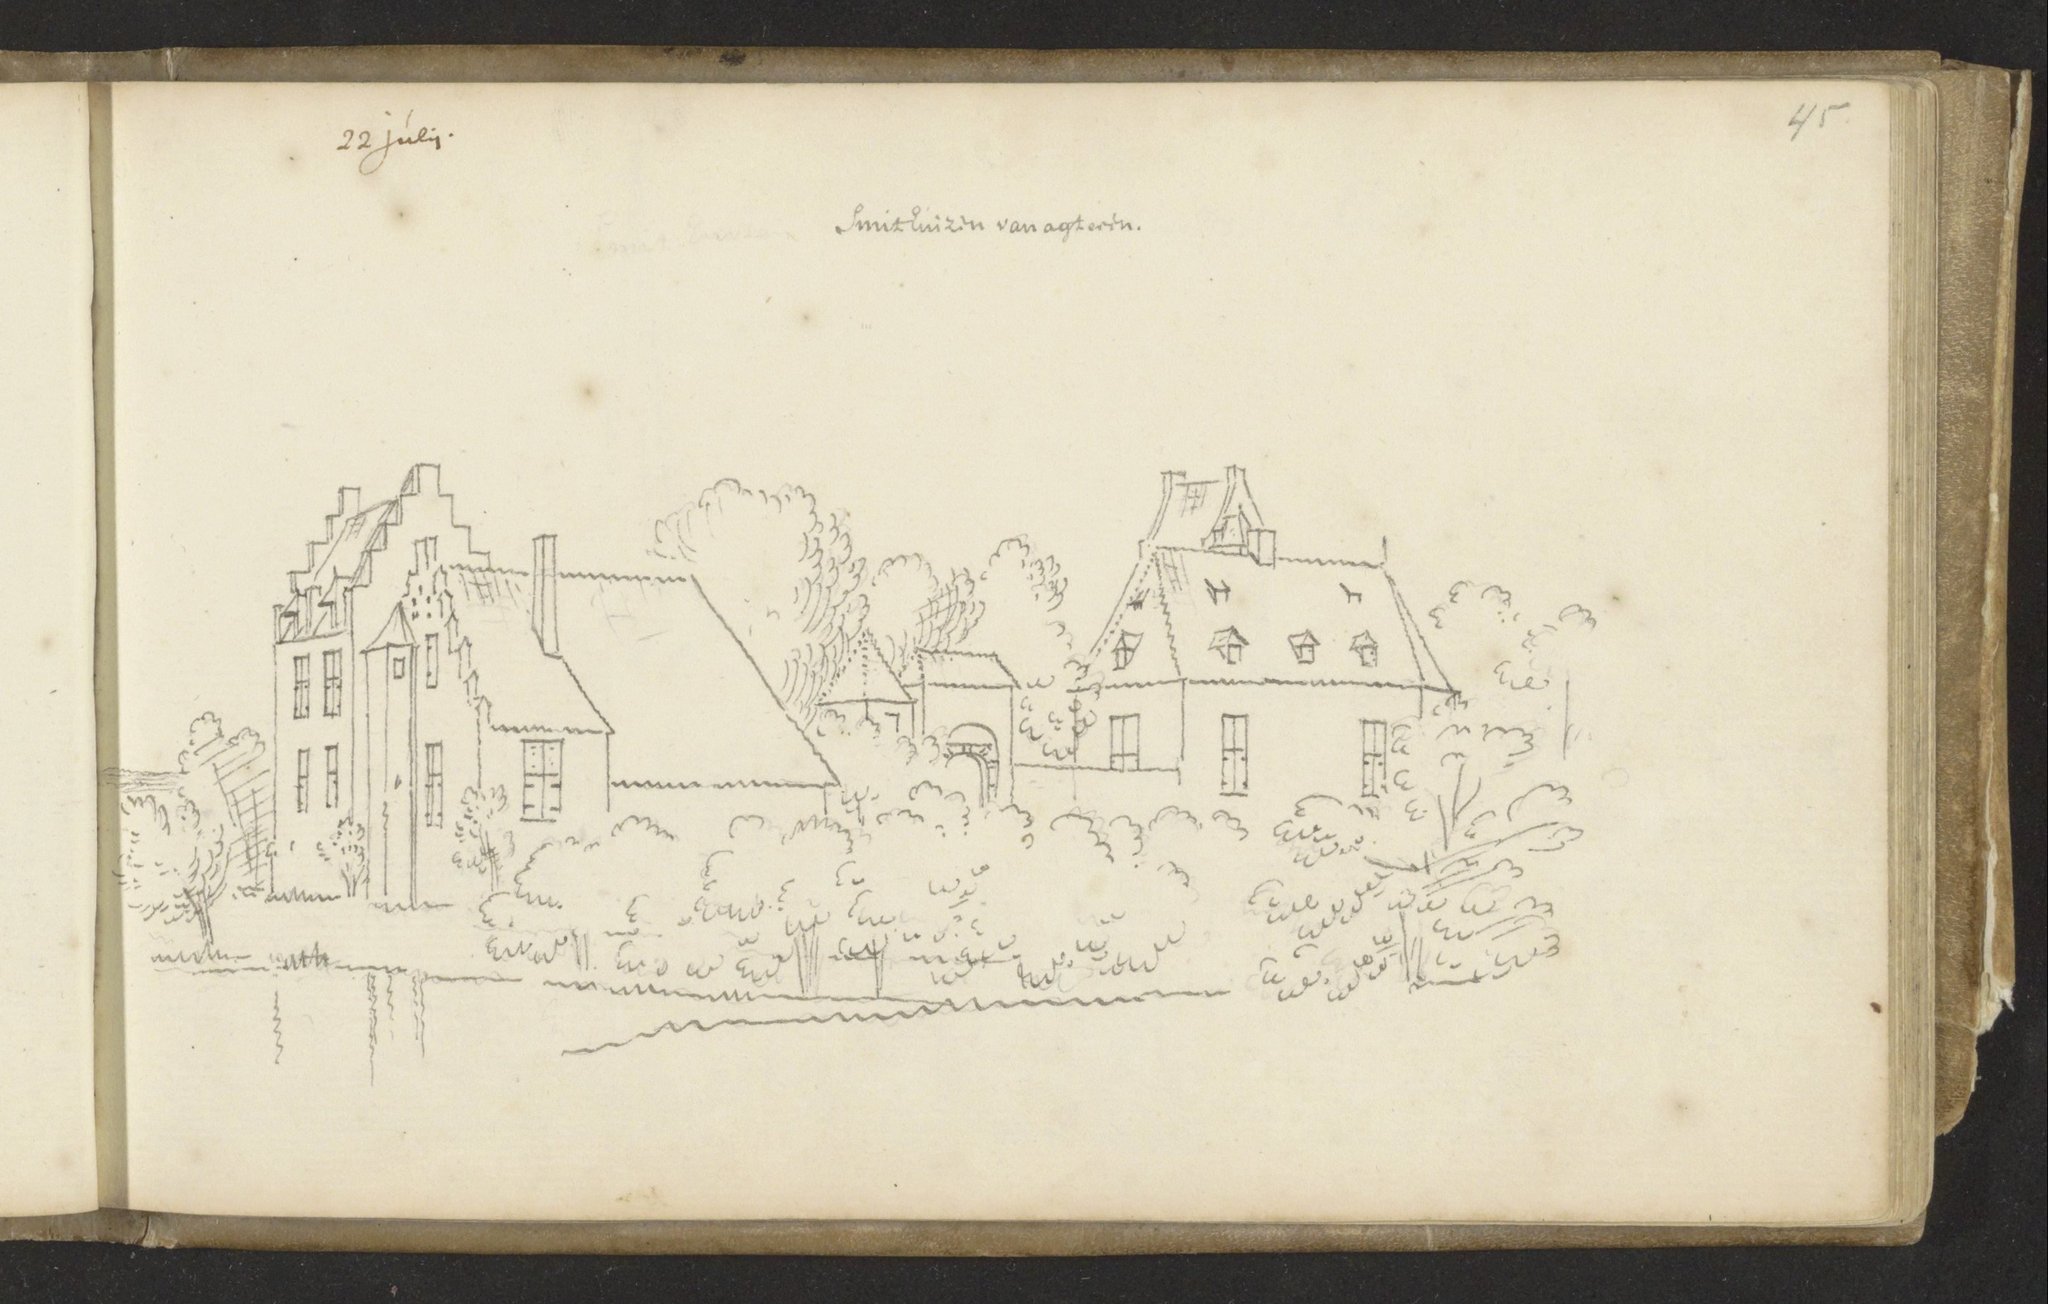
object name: sketchbook leaf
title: Huis Schmithausen te Kellen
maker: abraham de haen (ii)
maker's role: draughtsman, print maker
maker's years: 1707-1748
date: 1731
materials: ink, paper, pencil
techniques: pen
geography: kellen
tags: castle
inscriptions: date and inscription: ‘22 julij/ Smithuizen van agteren’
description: Blad 45 recto uit een schetsboek met 69 bladen.